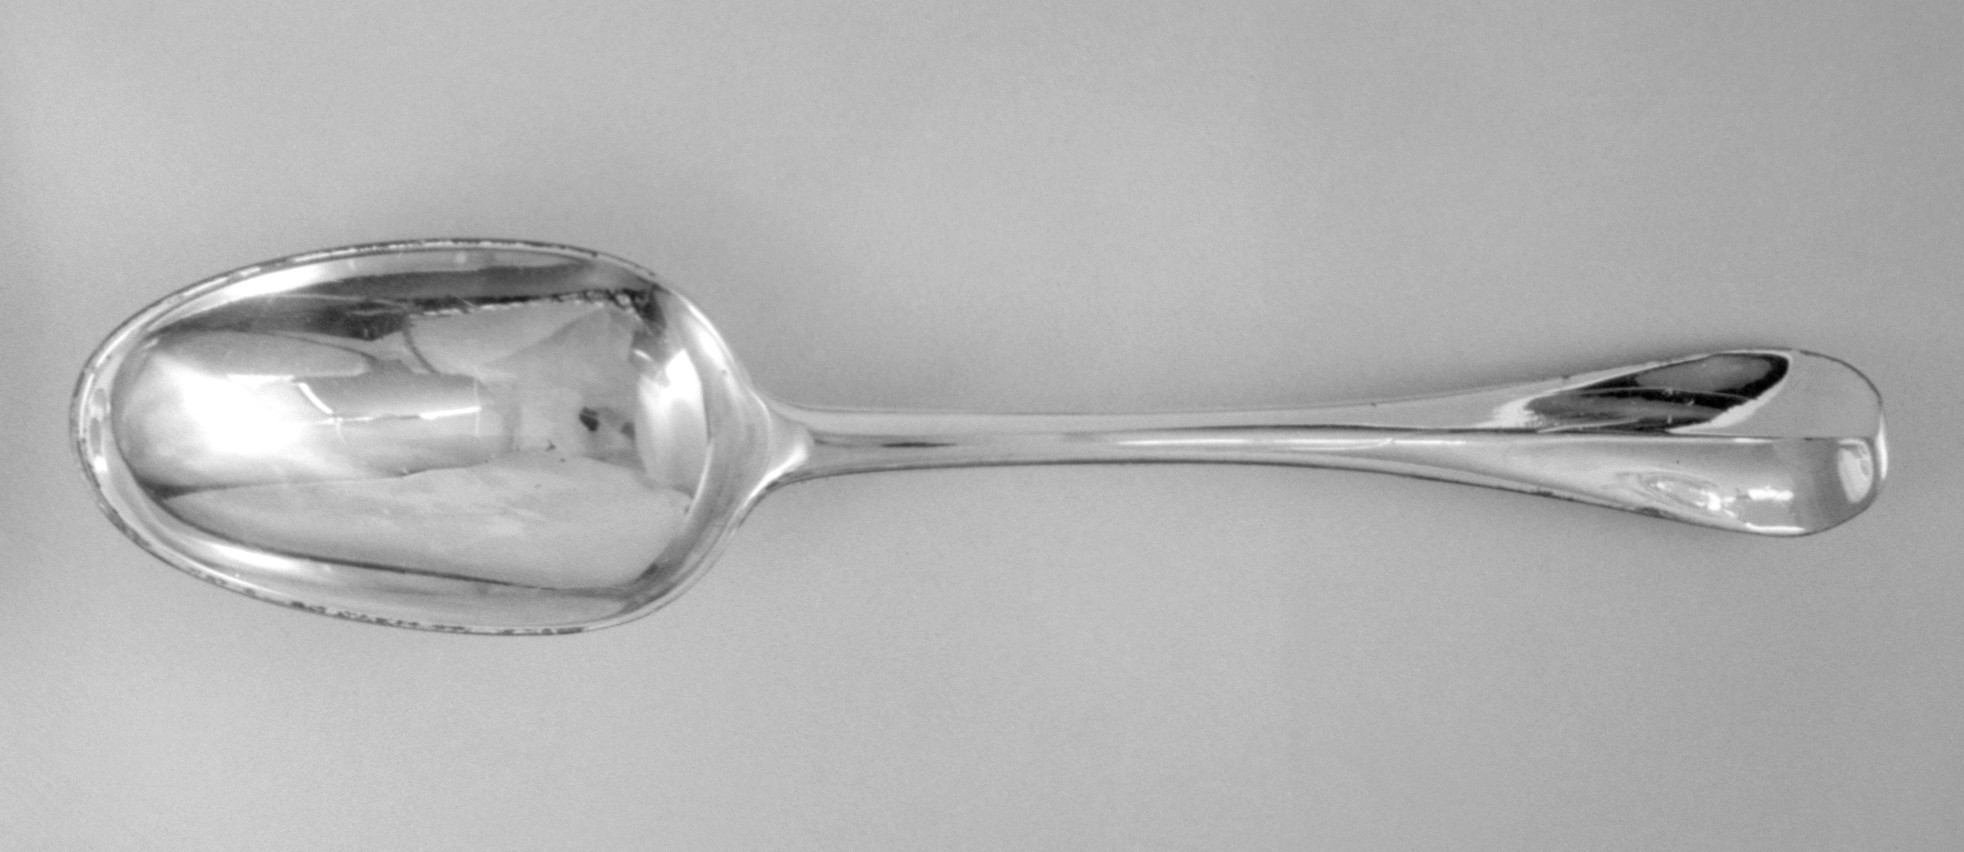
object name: spoon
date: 1719-1720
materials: silver